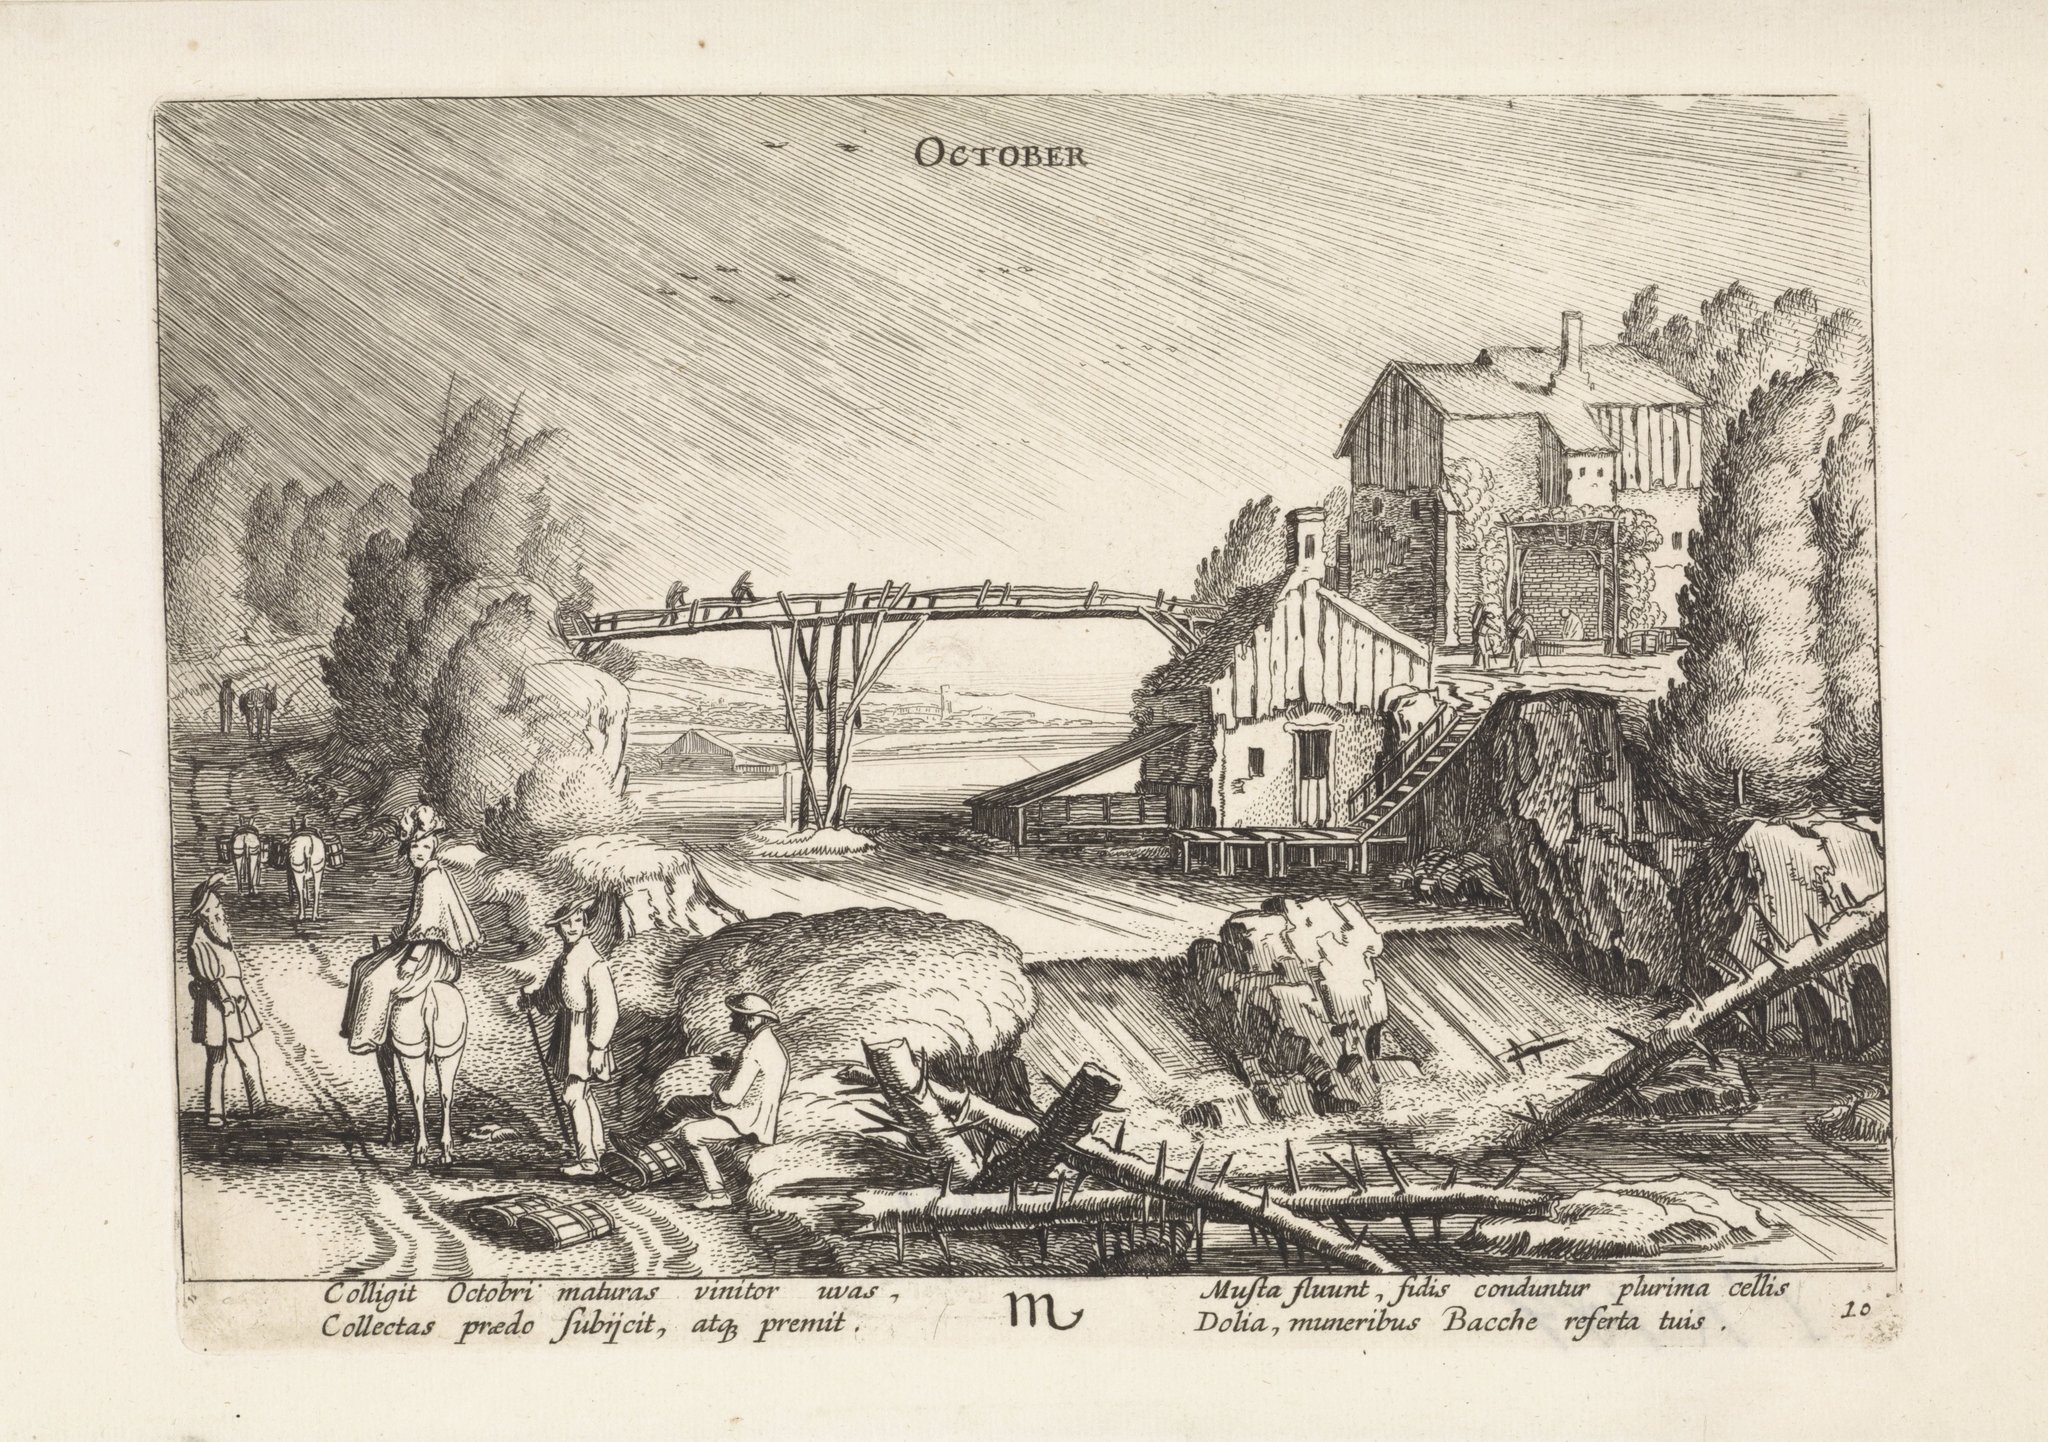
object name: print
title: Duodecim anni mensium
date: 1608-1618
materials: paper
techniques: engraving, etching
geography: northern netherlands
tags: landscape symbolizing september, libra (zodiacal sign of september), landscape with tower or castle, tow-boat, towing-barge, towing path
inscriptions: collector's mark: Lugt 964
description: Een rivierlandschap met figuren op een landweg in de regen, voorstellende de maand oktober. In het midden een houten brug. Rechts een huis met een man in een wijnkuip. Onderaan het astrologische symbool van het sterrenbeeld schorpioen. Prent uit een serie van twaalf.